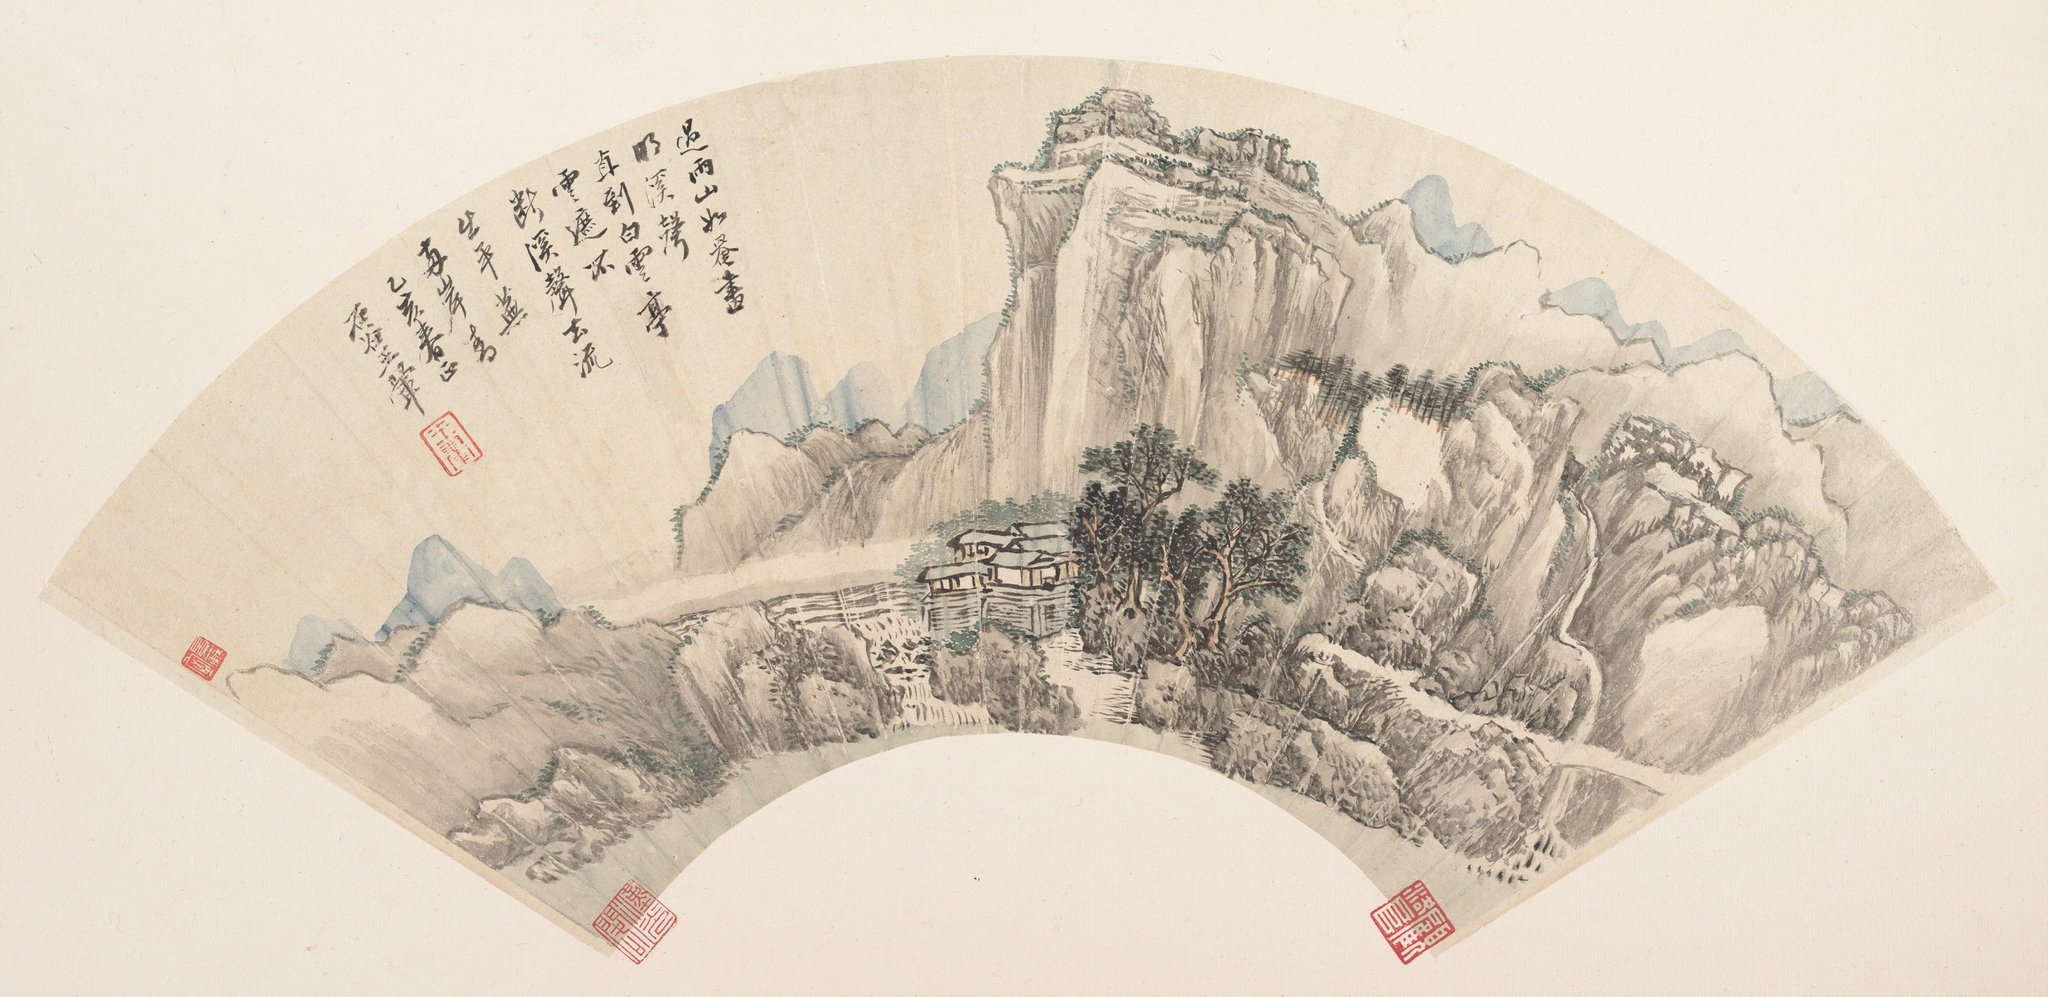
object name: folding fan mounted a an album leaf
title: Mountains after Rain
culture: chinese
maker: wang hui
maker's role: artist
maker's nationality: chinese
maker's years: 1632-1717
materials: ink, paper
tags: houses,mountains,trees